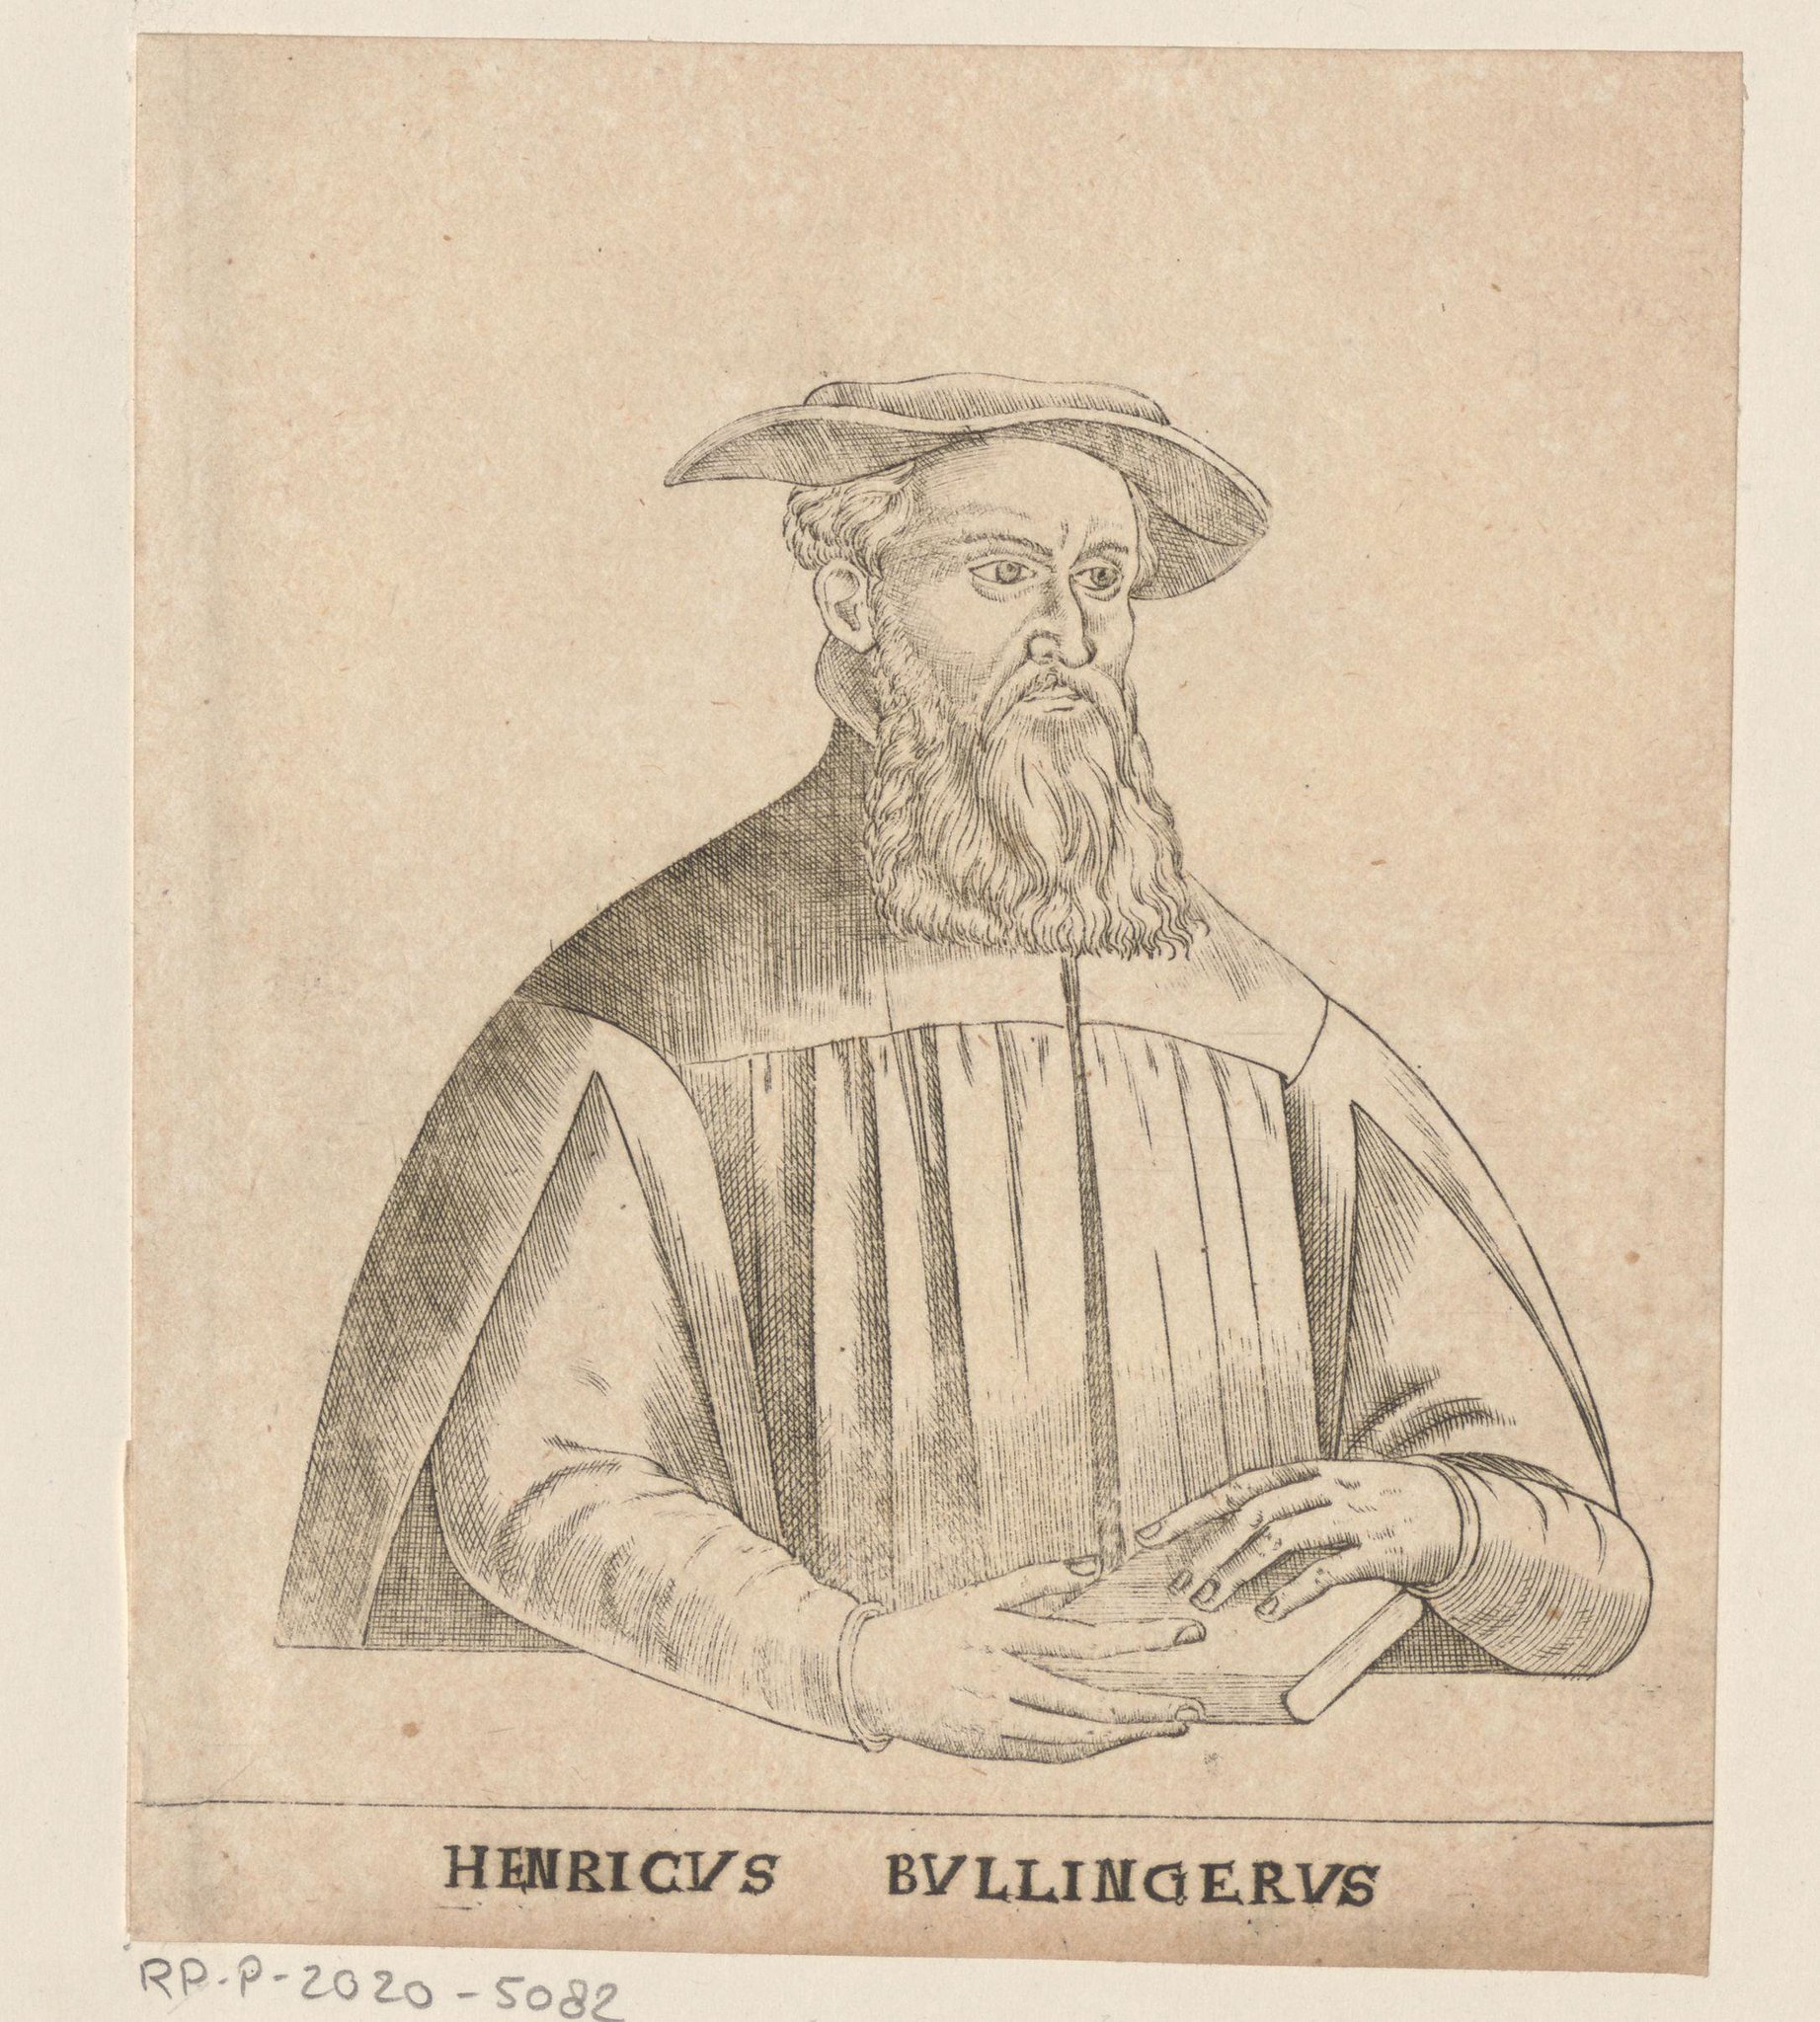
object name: print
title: Portret van Johann Heinrich Bullinger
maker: Anonymous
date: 1700-1749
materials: paper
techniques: engraving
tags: theologian, historical persons